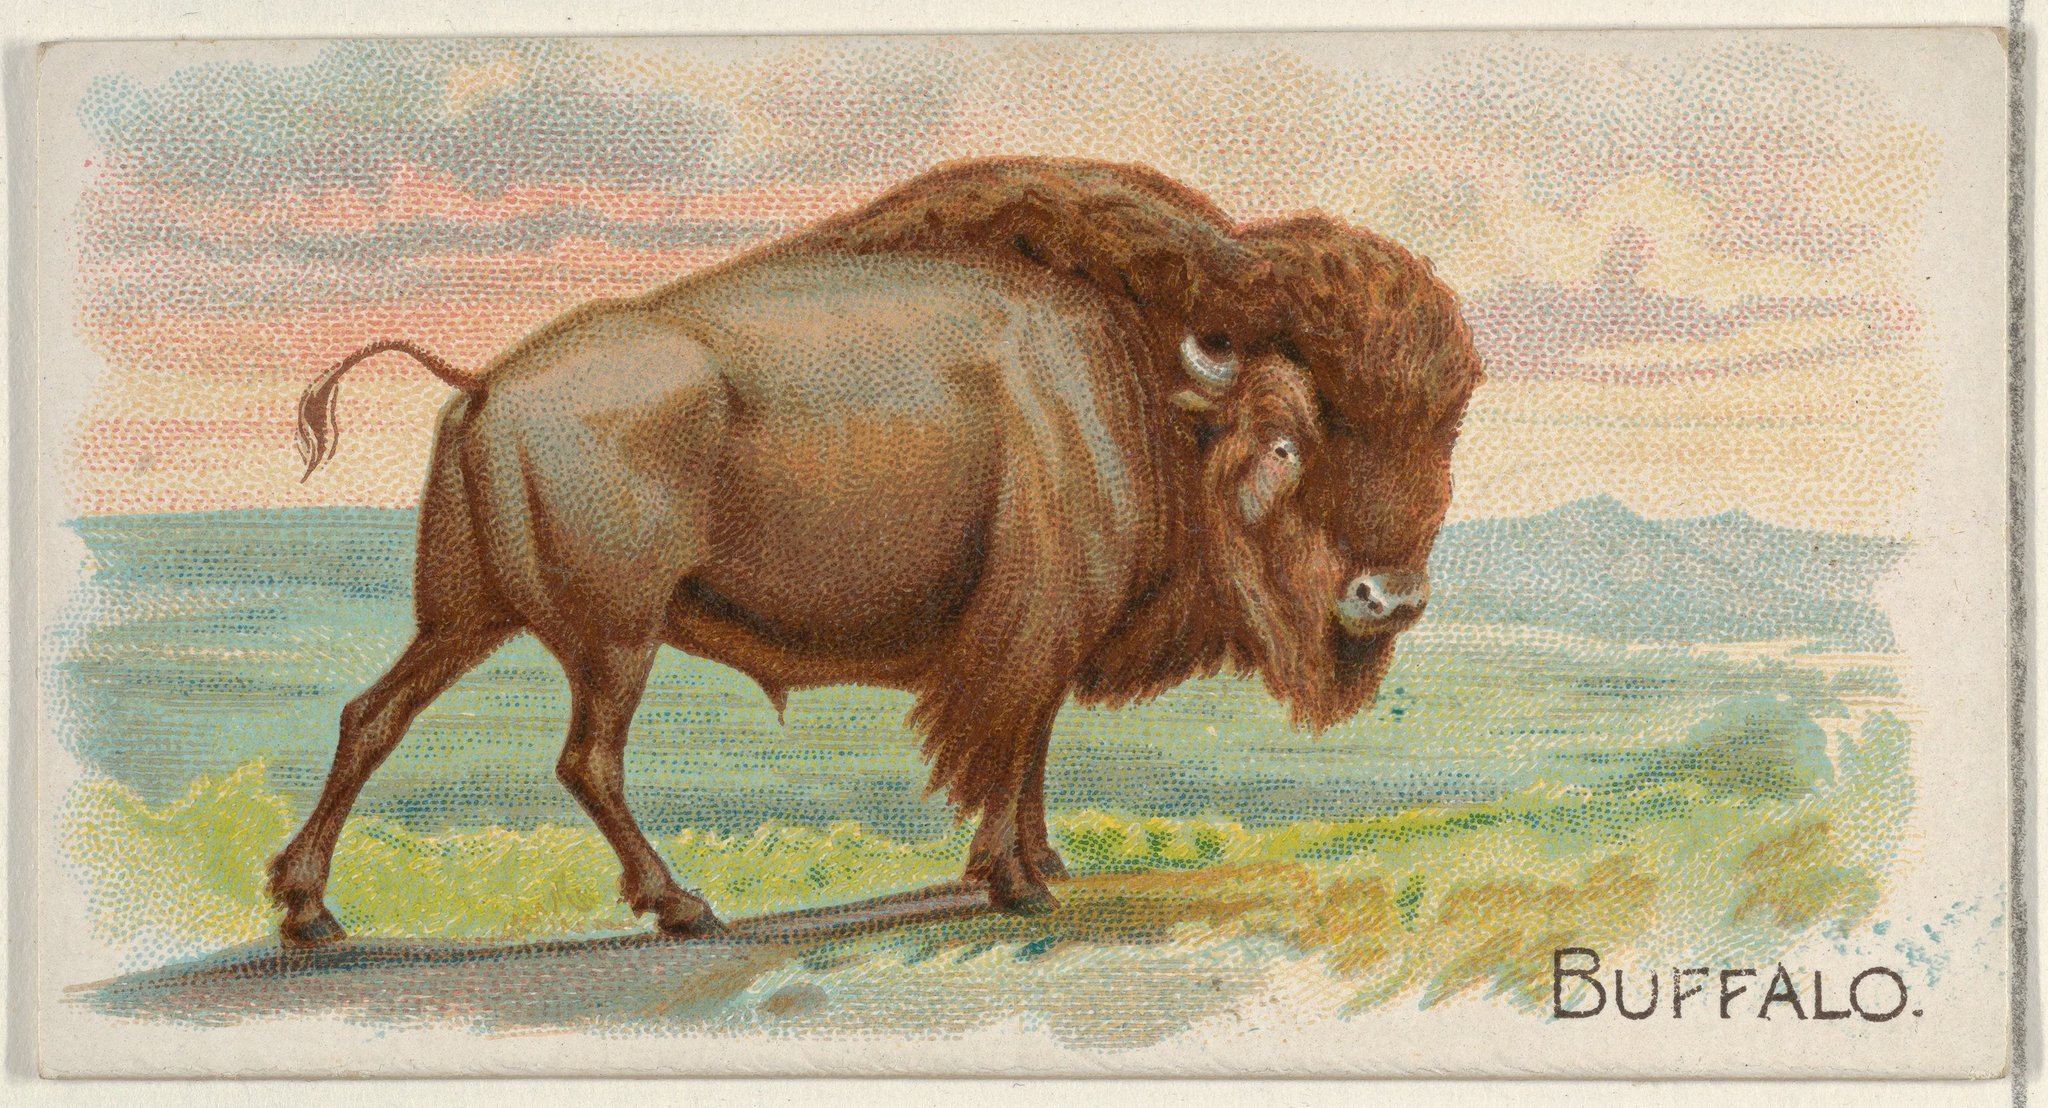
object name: print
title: Buffalo, from the Quadrupeds series (N21) for Allen & Ginter Cigarettes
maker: allen & ginter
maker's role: publisher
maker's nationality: american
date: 1890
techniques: color lithograph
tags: buffalos